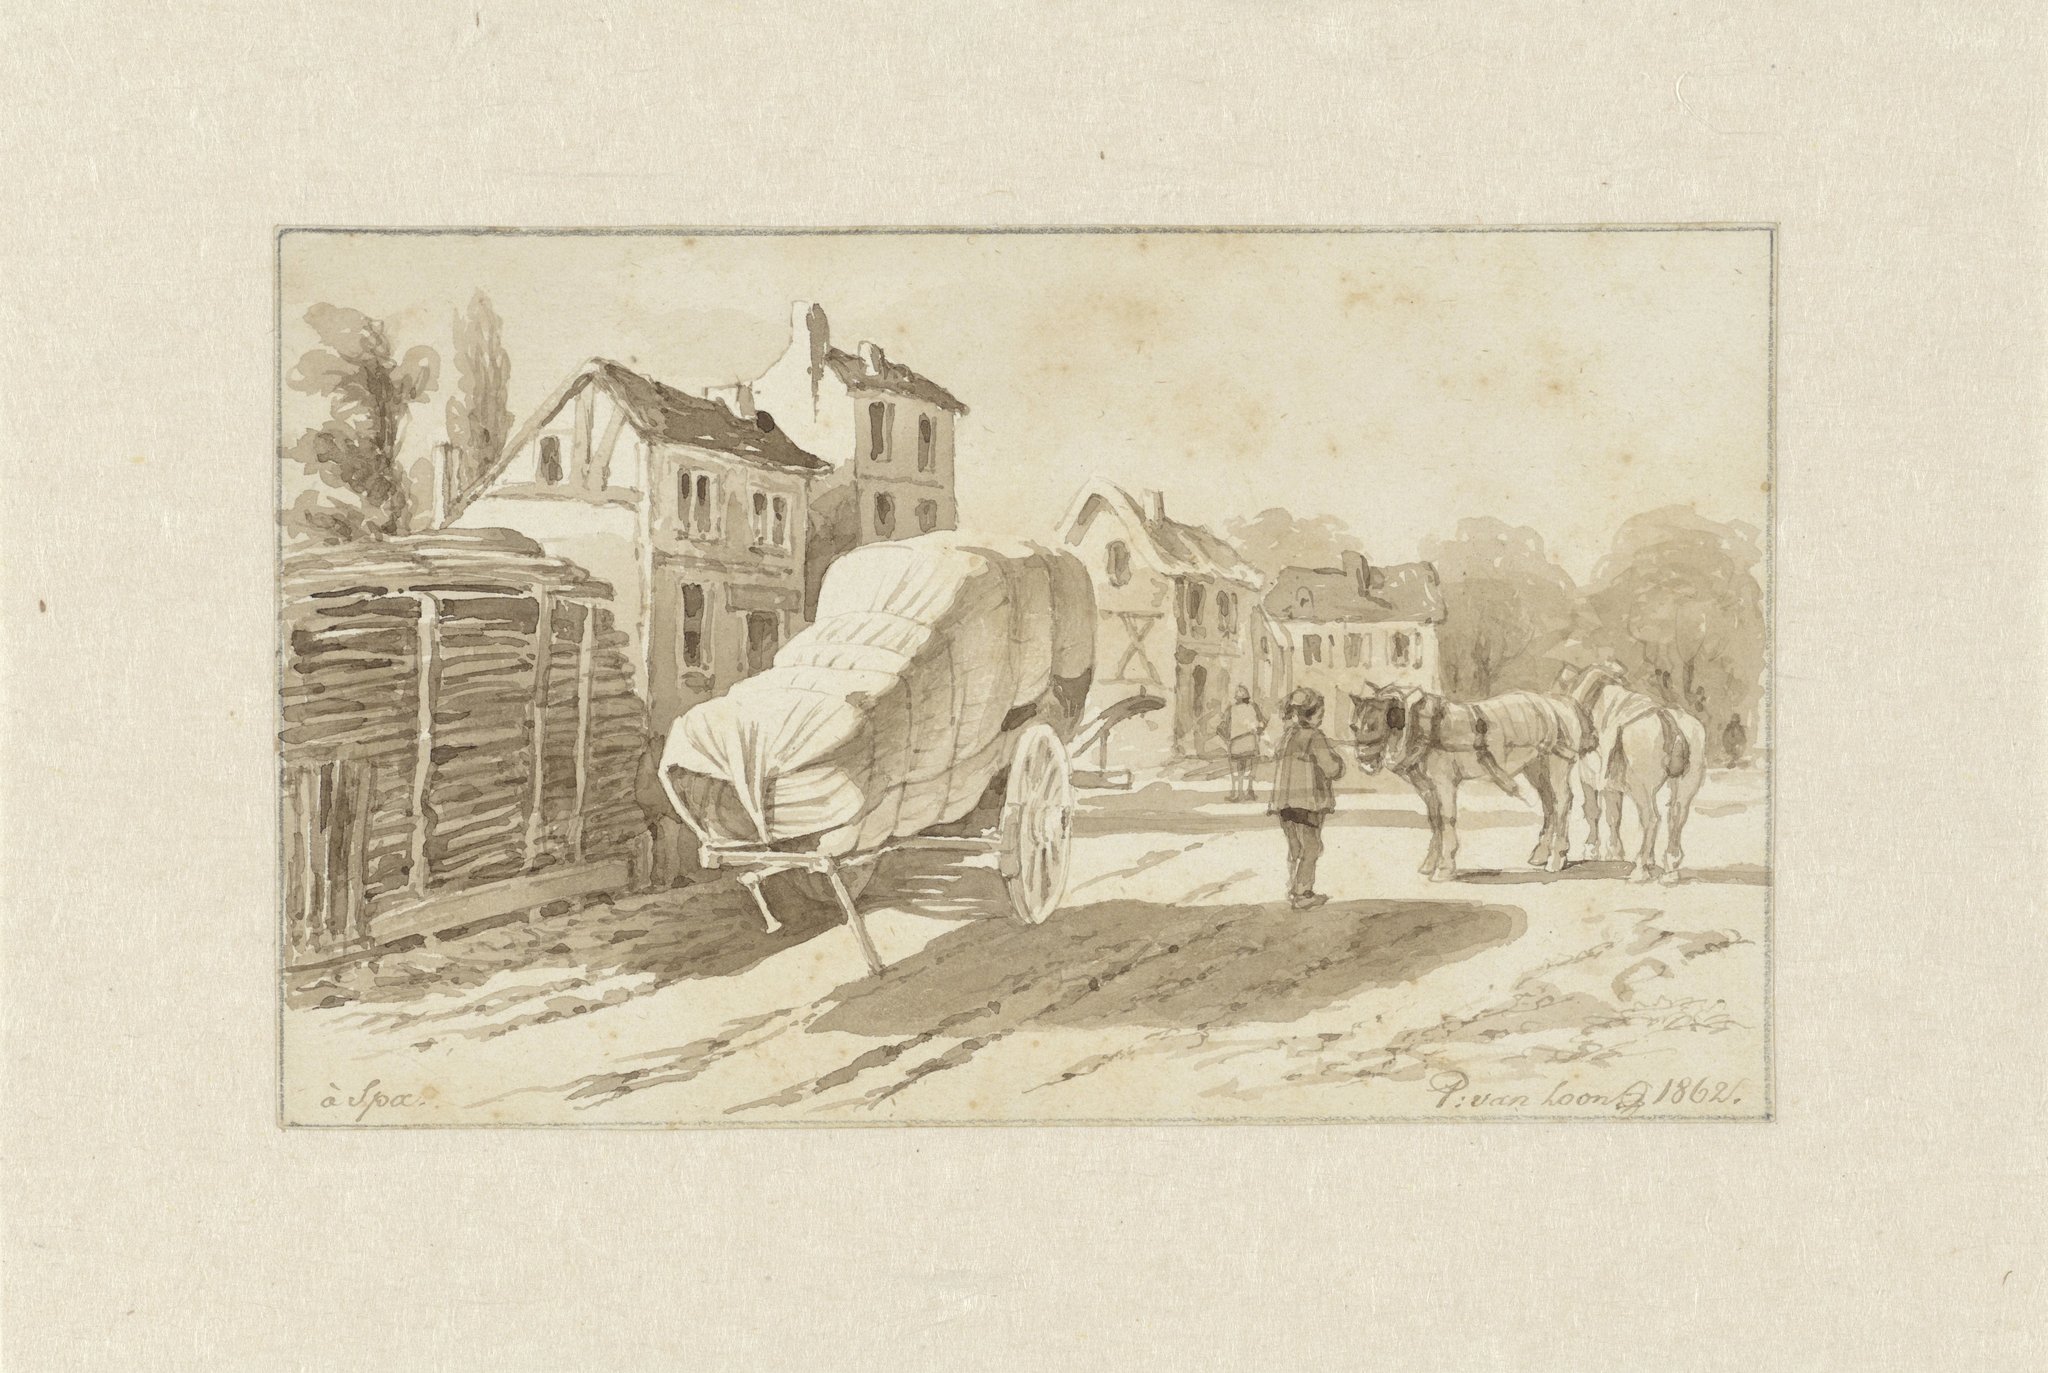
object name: drawing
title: gezicht in Spa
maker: pieter van loon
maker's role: draughtsman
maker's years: 1801-1873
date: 1862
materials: paper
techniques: brush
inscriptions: inscription: ‘à Spa’, signature and date: ‘P: van Loon 1862’